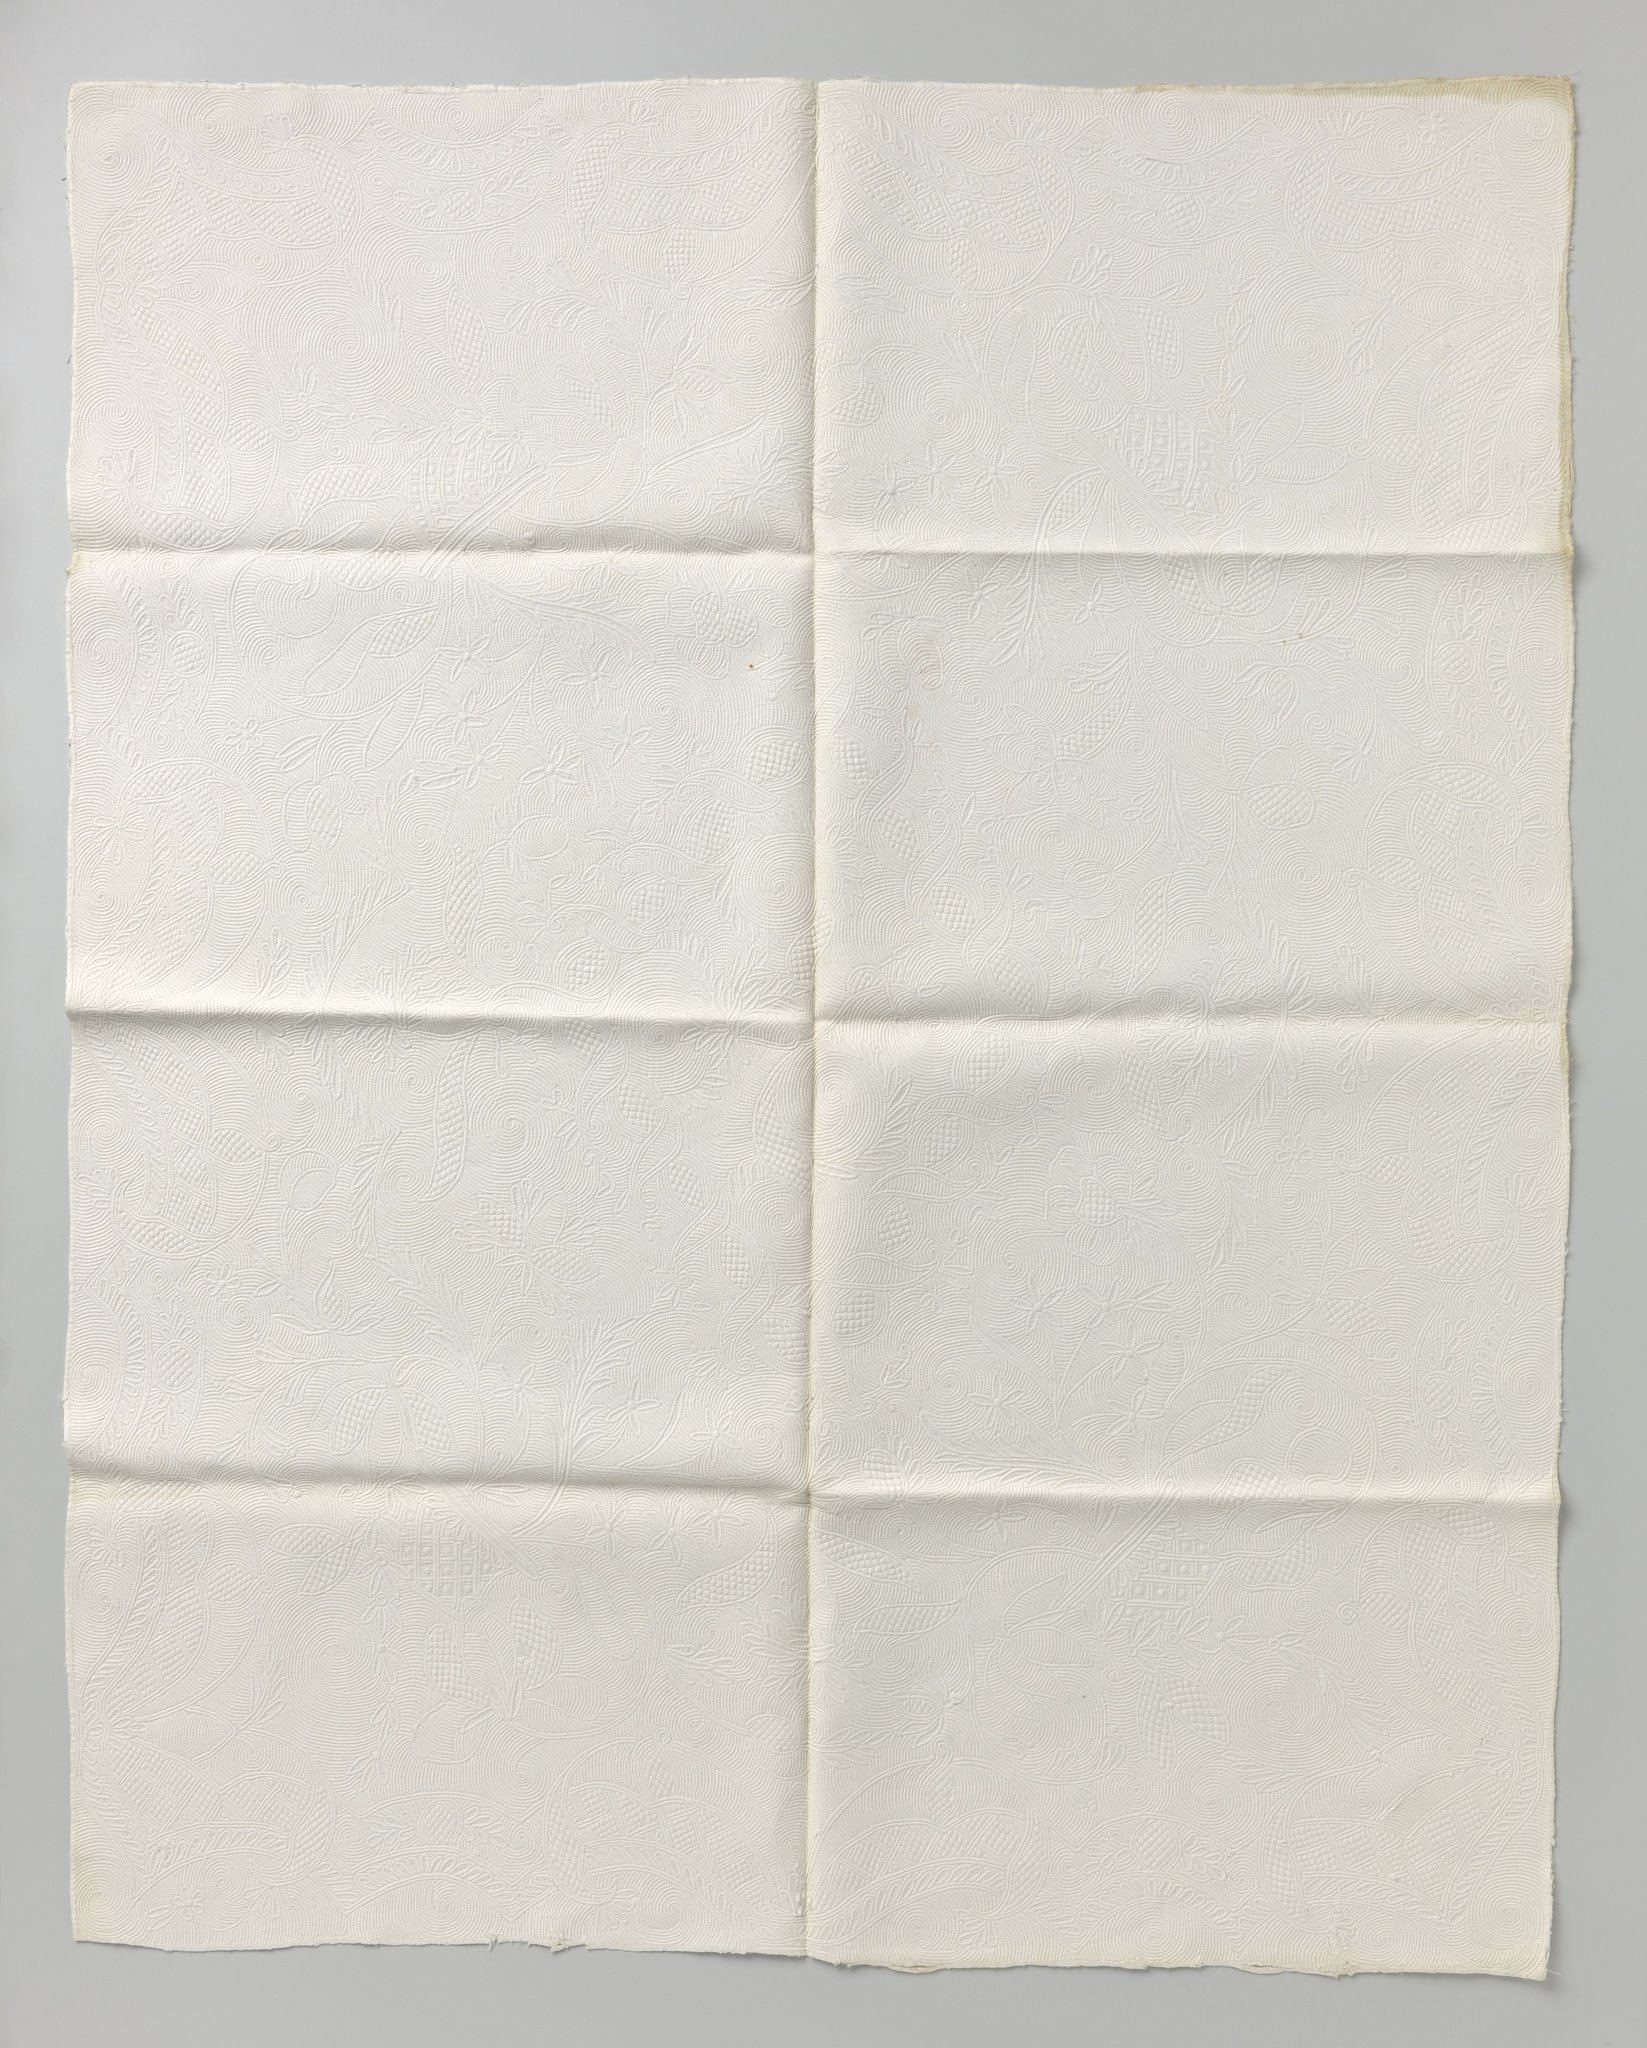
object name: kindersprei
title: Kindersprei of kleed van Zaans stikwerk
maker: Anonymous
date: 1730-1770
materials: cotton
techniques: embroidered, quilting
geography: netherlands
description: Kindersprei of kleed van Zaans stikwerk met bloemenmanden in de hoeken.